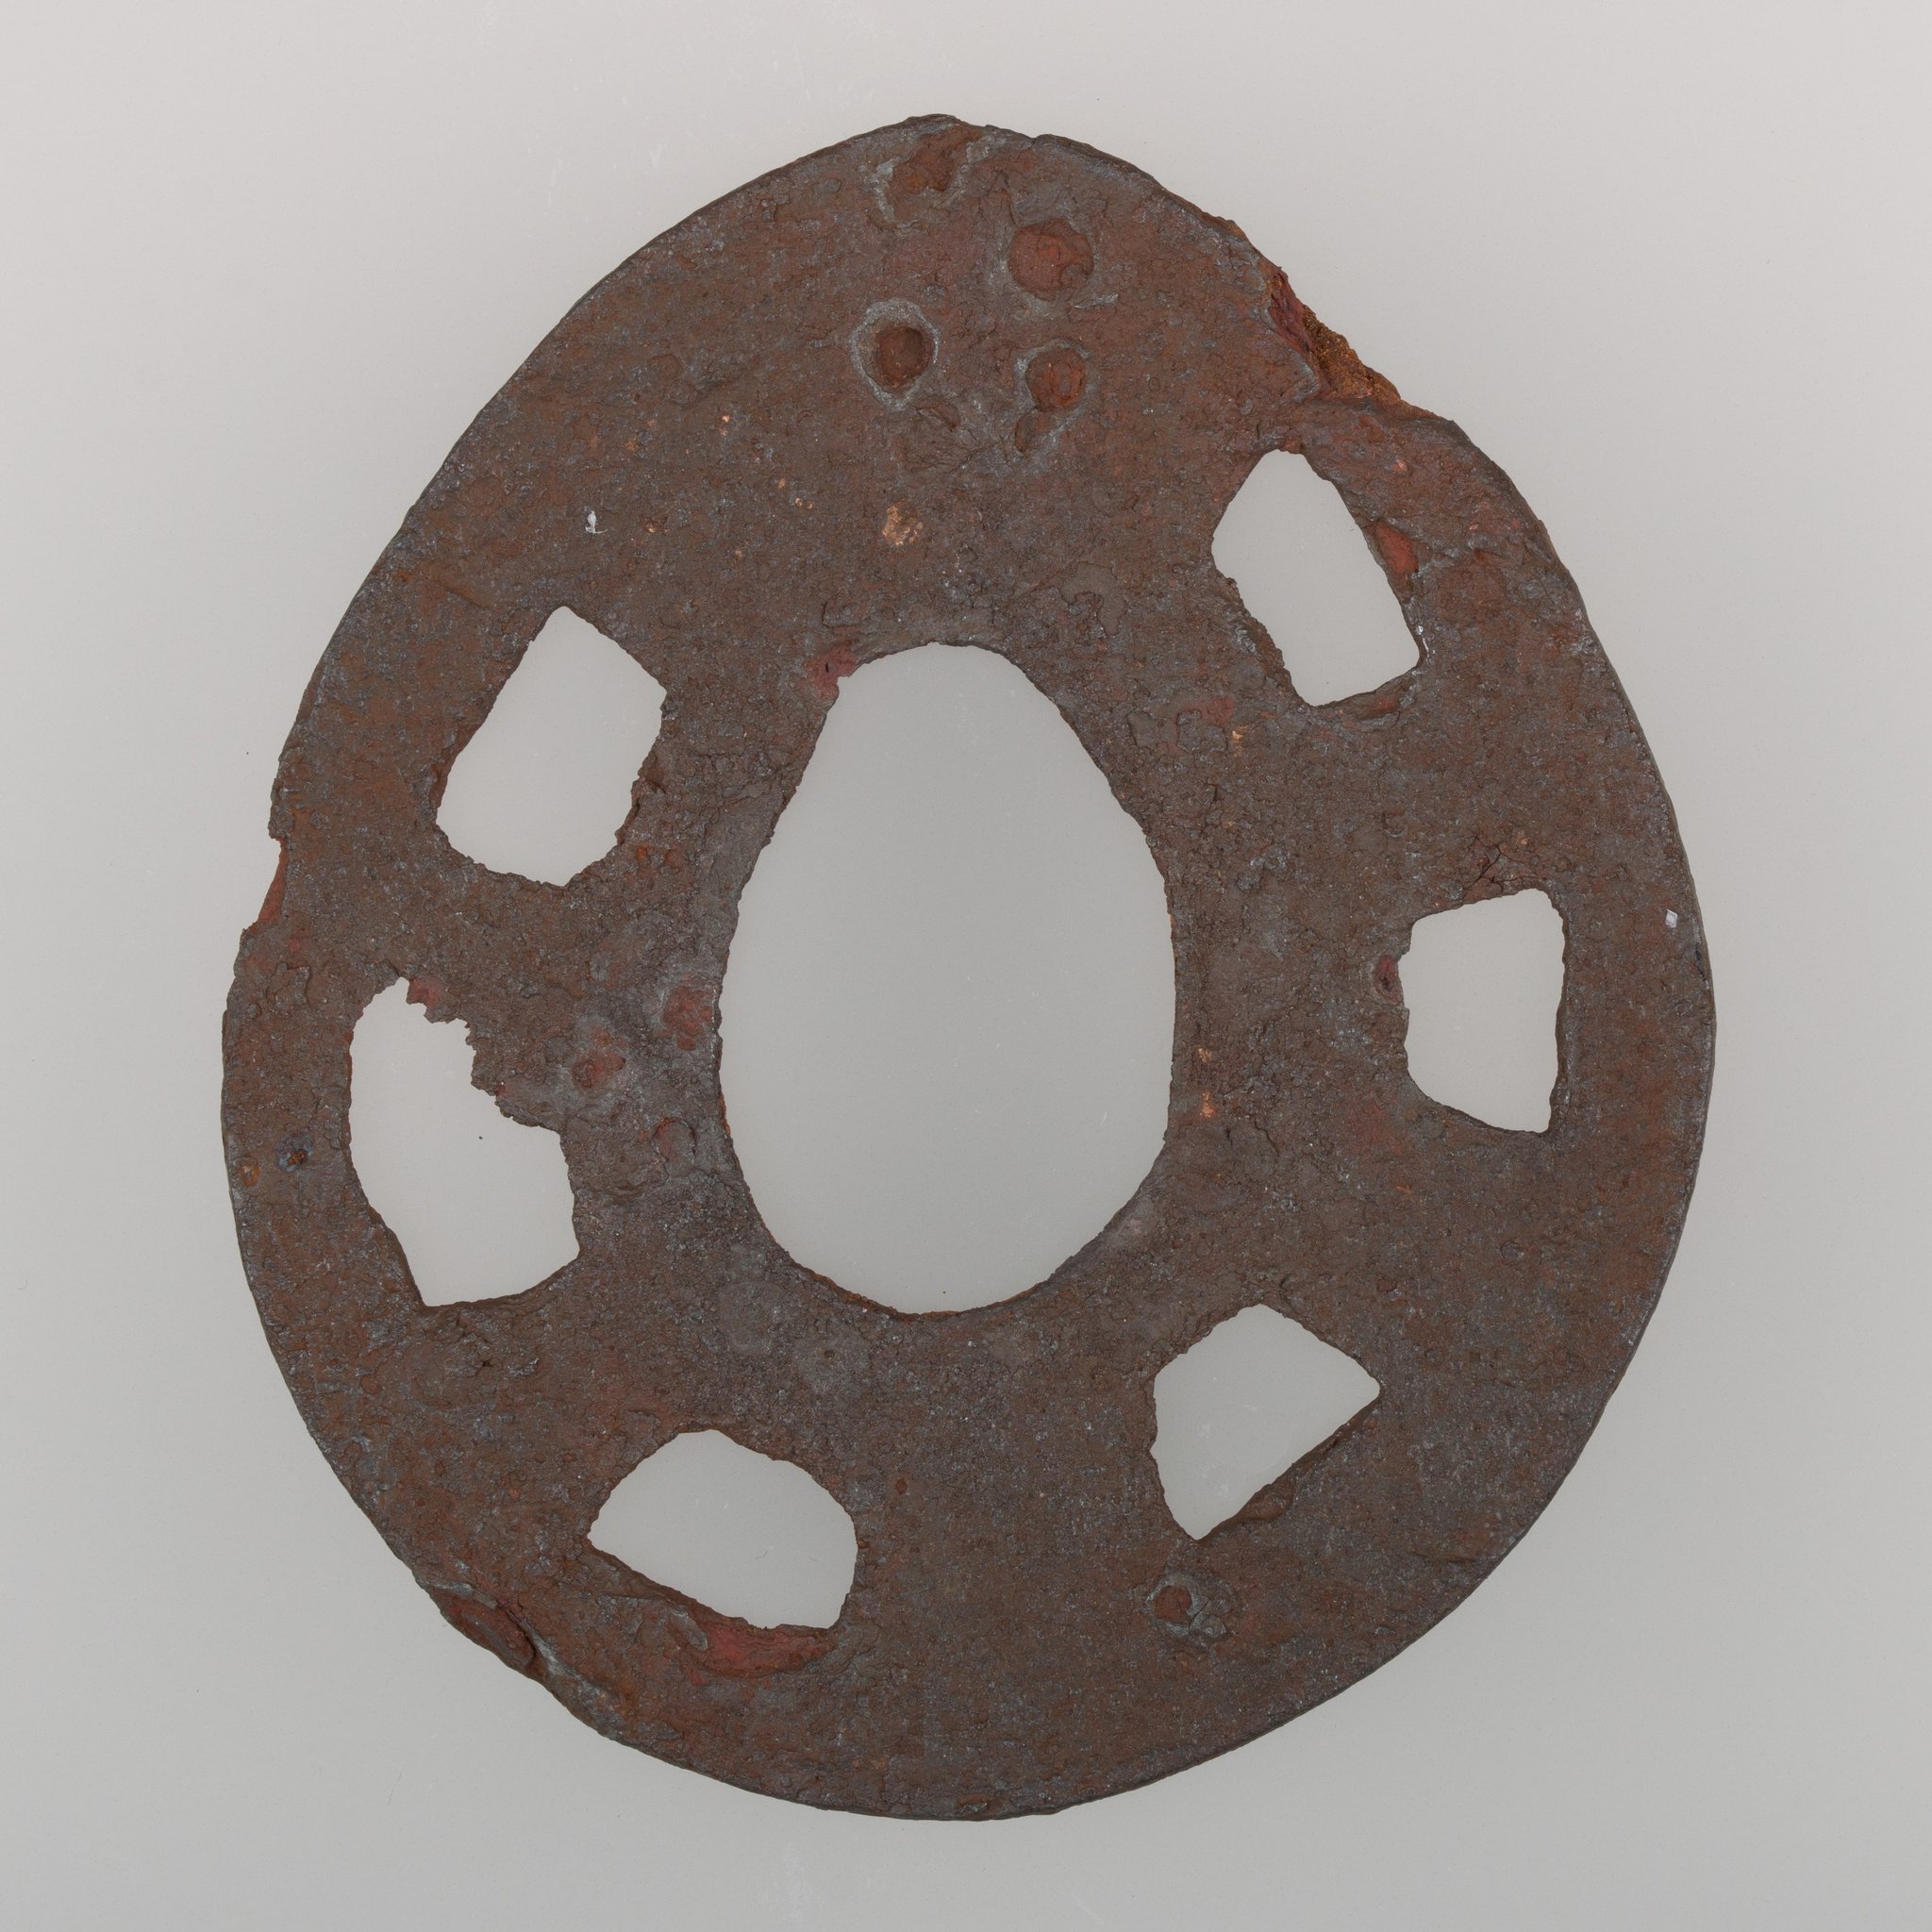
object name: sword guard tsuba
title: Sword Guard (Tsuba)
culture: japanese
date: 201-300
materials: iron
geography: japan